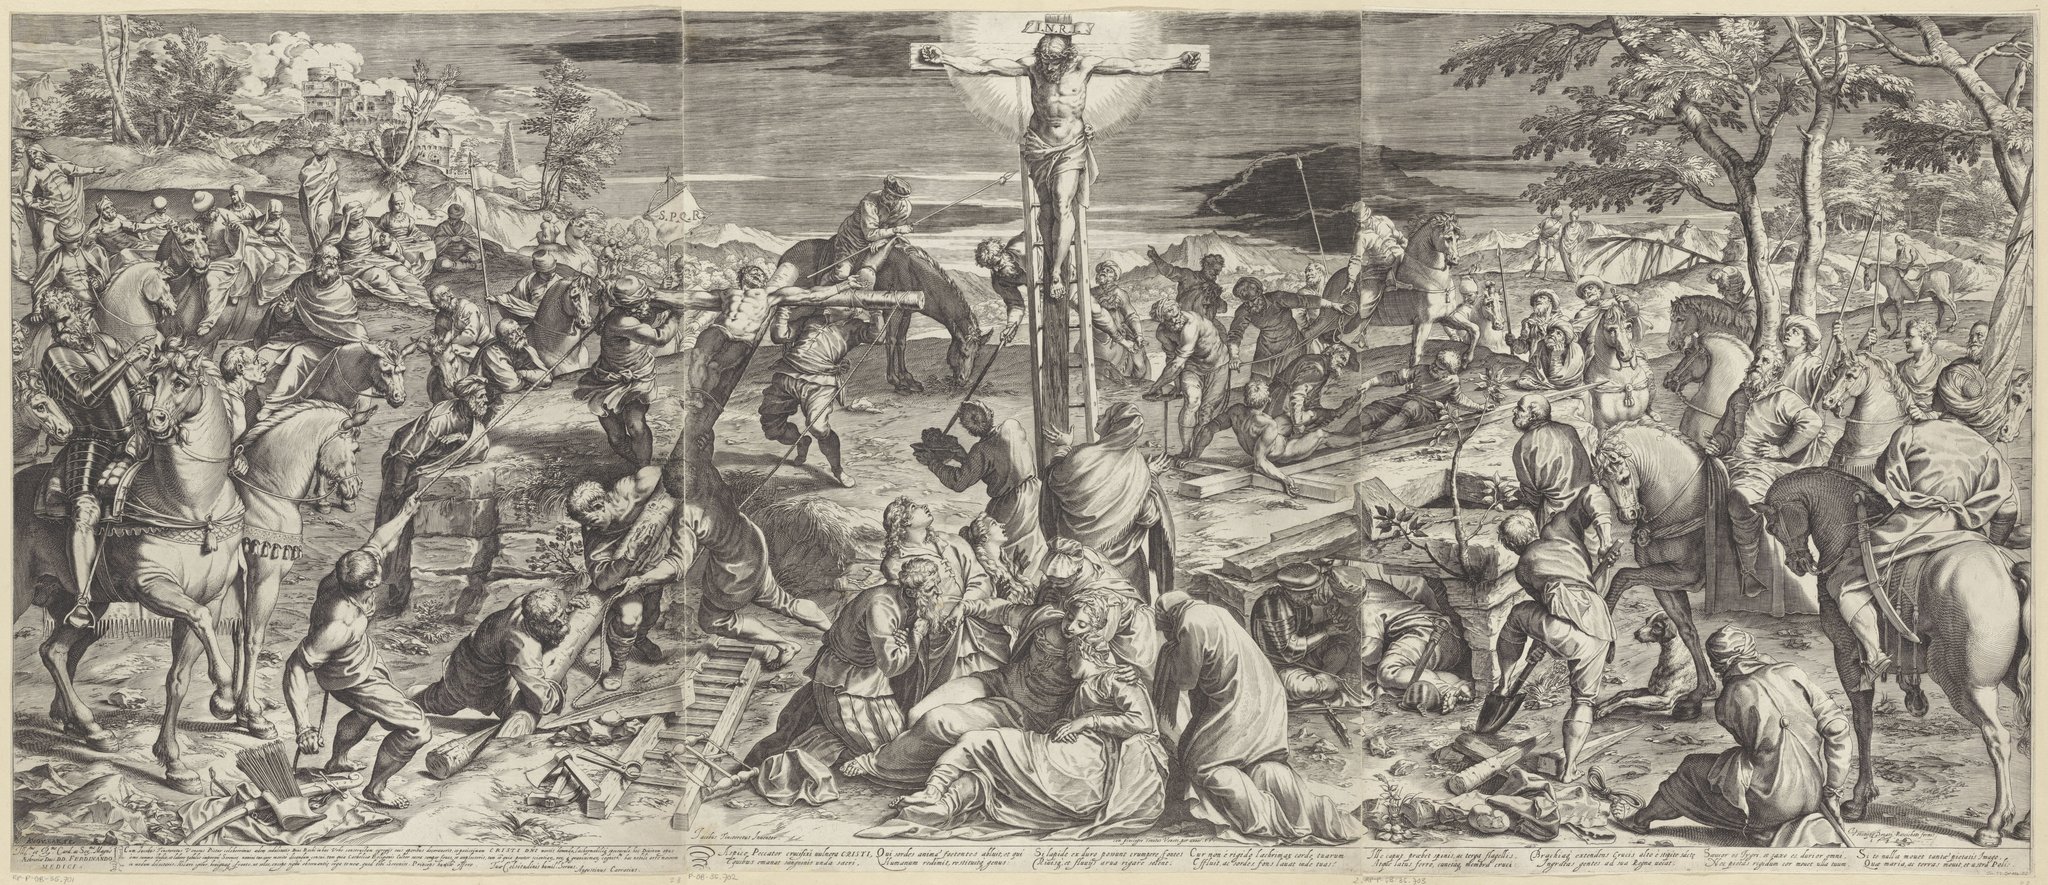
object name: print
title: Kruisiging van Christus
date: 1589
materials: paper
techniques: engraving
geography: venice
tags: the crucifixion of christ: christ's death on the cross; golgotha (matthew 27:45-58; mark 15:33-45; luke 23:44-52; john 19:25-38)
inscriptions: collector's mark: Lugt 240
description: Kruisdood van Christus op Golgota. Christus hangt aan het kruis, links en rechts van hem worden de twee misdadigers gekruisigd. Longinus staat op het punt zijn lans in de zijde van Christus te steken. Een groep mannen op paarden en ezels kijkt toe. De Maria's en Johannes treuren onder het kruis. Tekst in het Latijn in ondermarge.